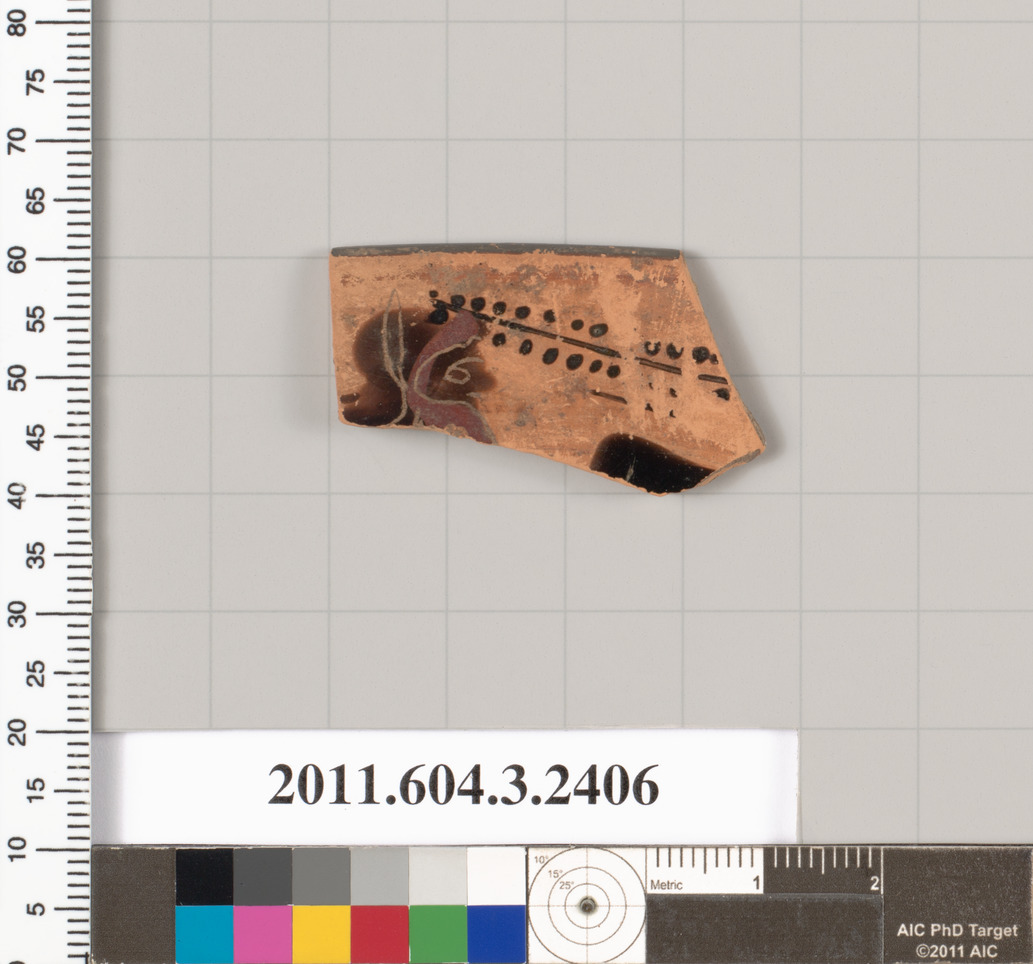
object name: kylix fragment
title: Terracotta rim fragment of a kylix: eye-cup (drinking cup)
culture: greek, attic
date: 525-501 BCE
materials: terracotta